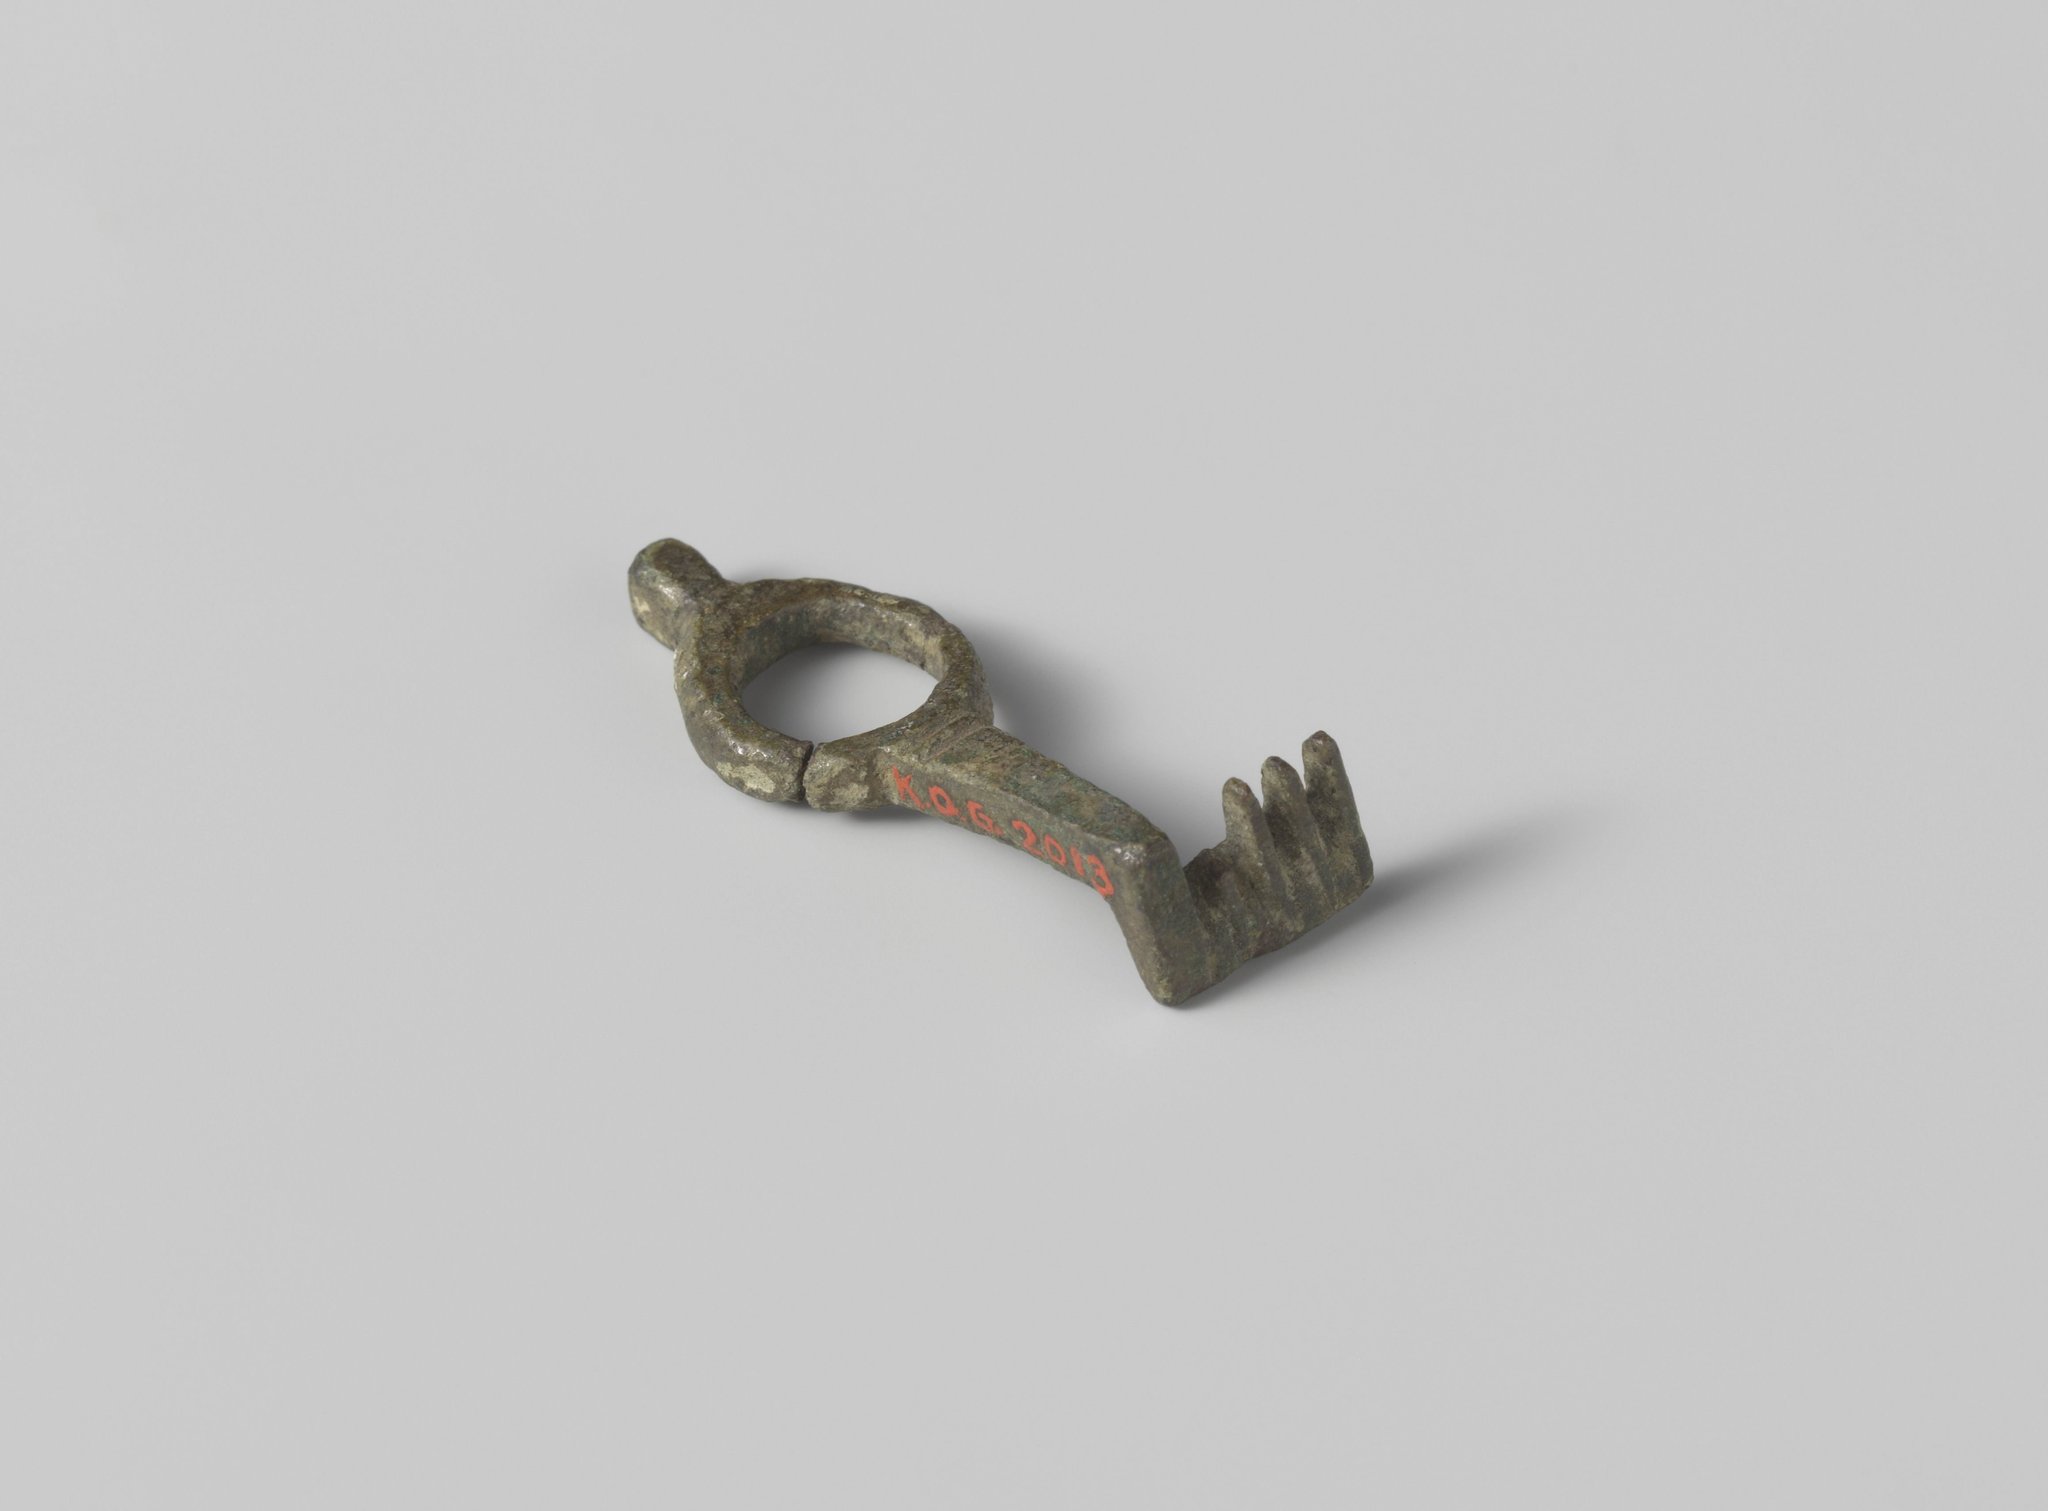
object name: key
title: Sleutel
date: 1400-1950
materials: bronze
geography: rome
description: Sleutel voorzien van eikelvormig oog met opstand. Een van de vier tanden van de baard ontbreekt.